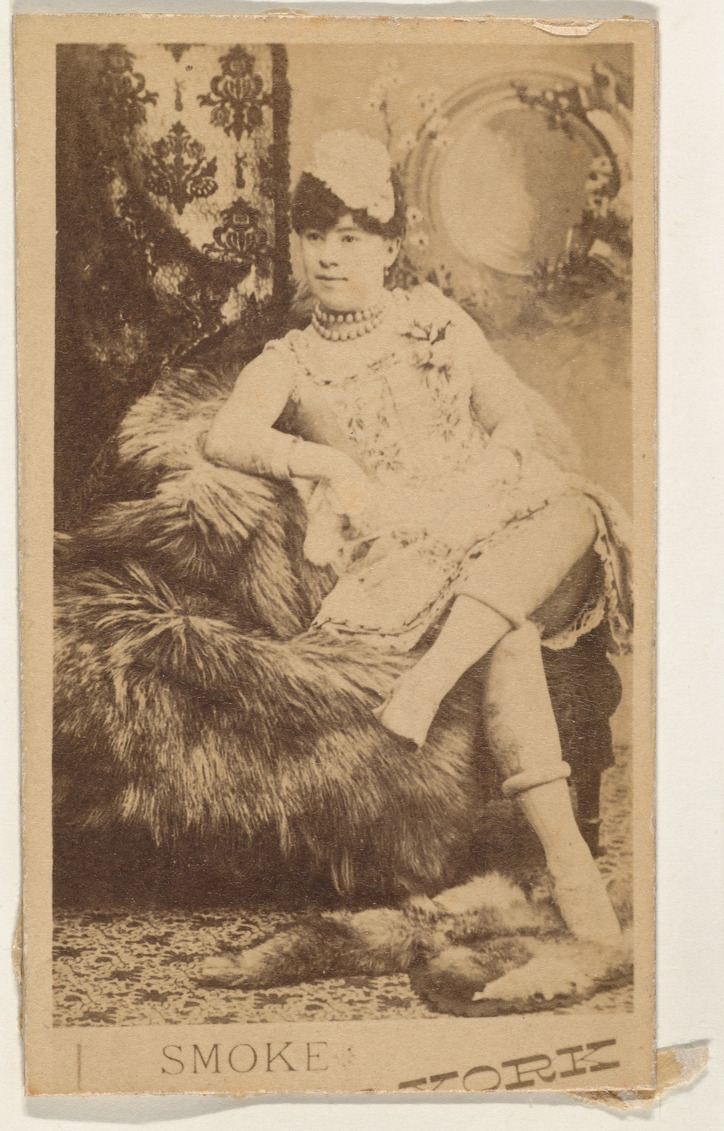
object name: photograph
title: Actress lounging on fur throw, from the series Actresses (N674), promoting New York Dandies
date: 1888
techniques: albumen silver print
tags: portraits,women,actresses